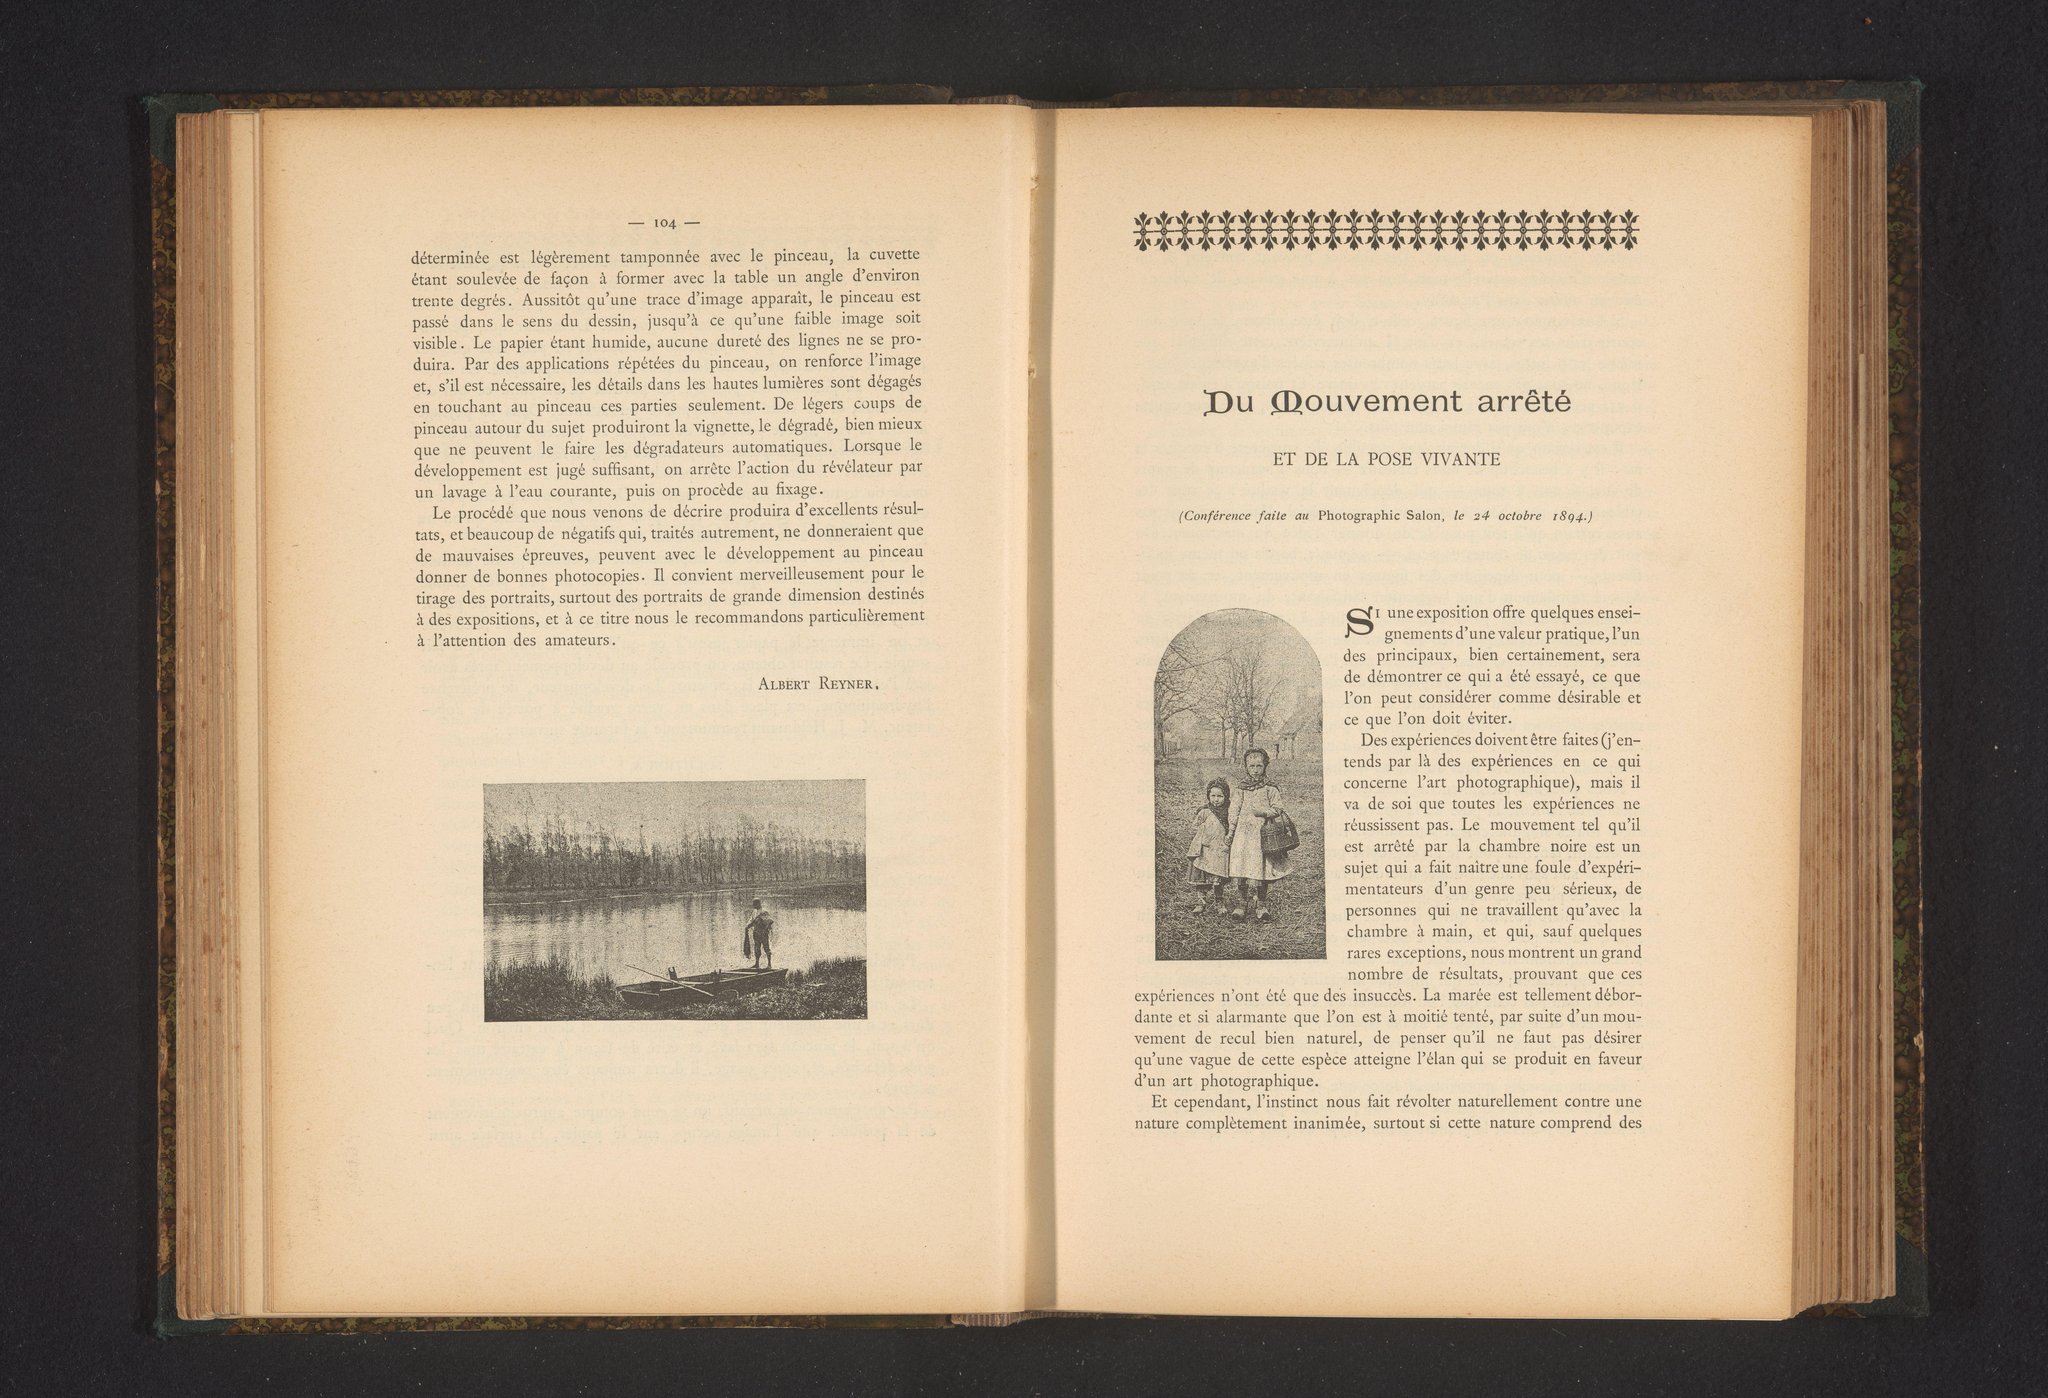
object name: page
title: Twee meisjes, waarvan één met een mand aan haar arm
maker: Anonymous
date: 1890-1895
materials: paper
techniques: photograph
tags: container made of plant material other than wood: basket, girl (child between toddler and youth)